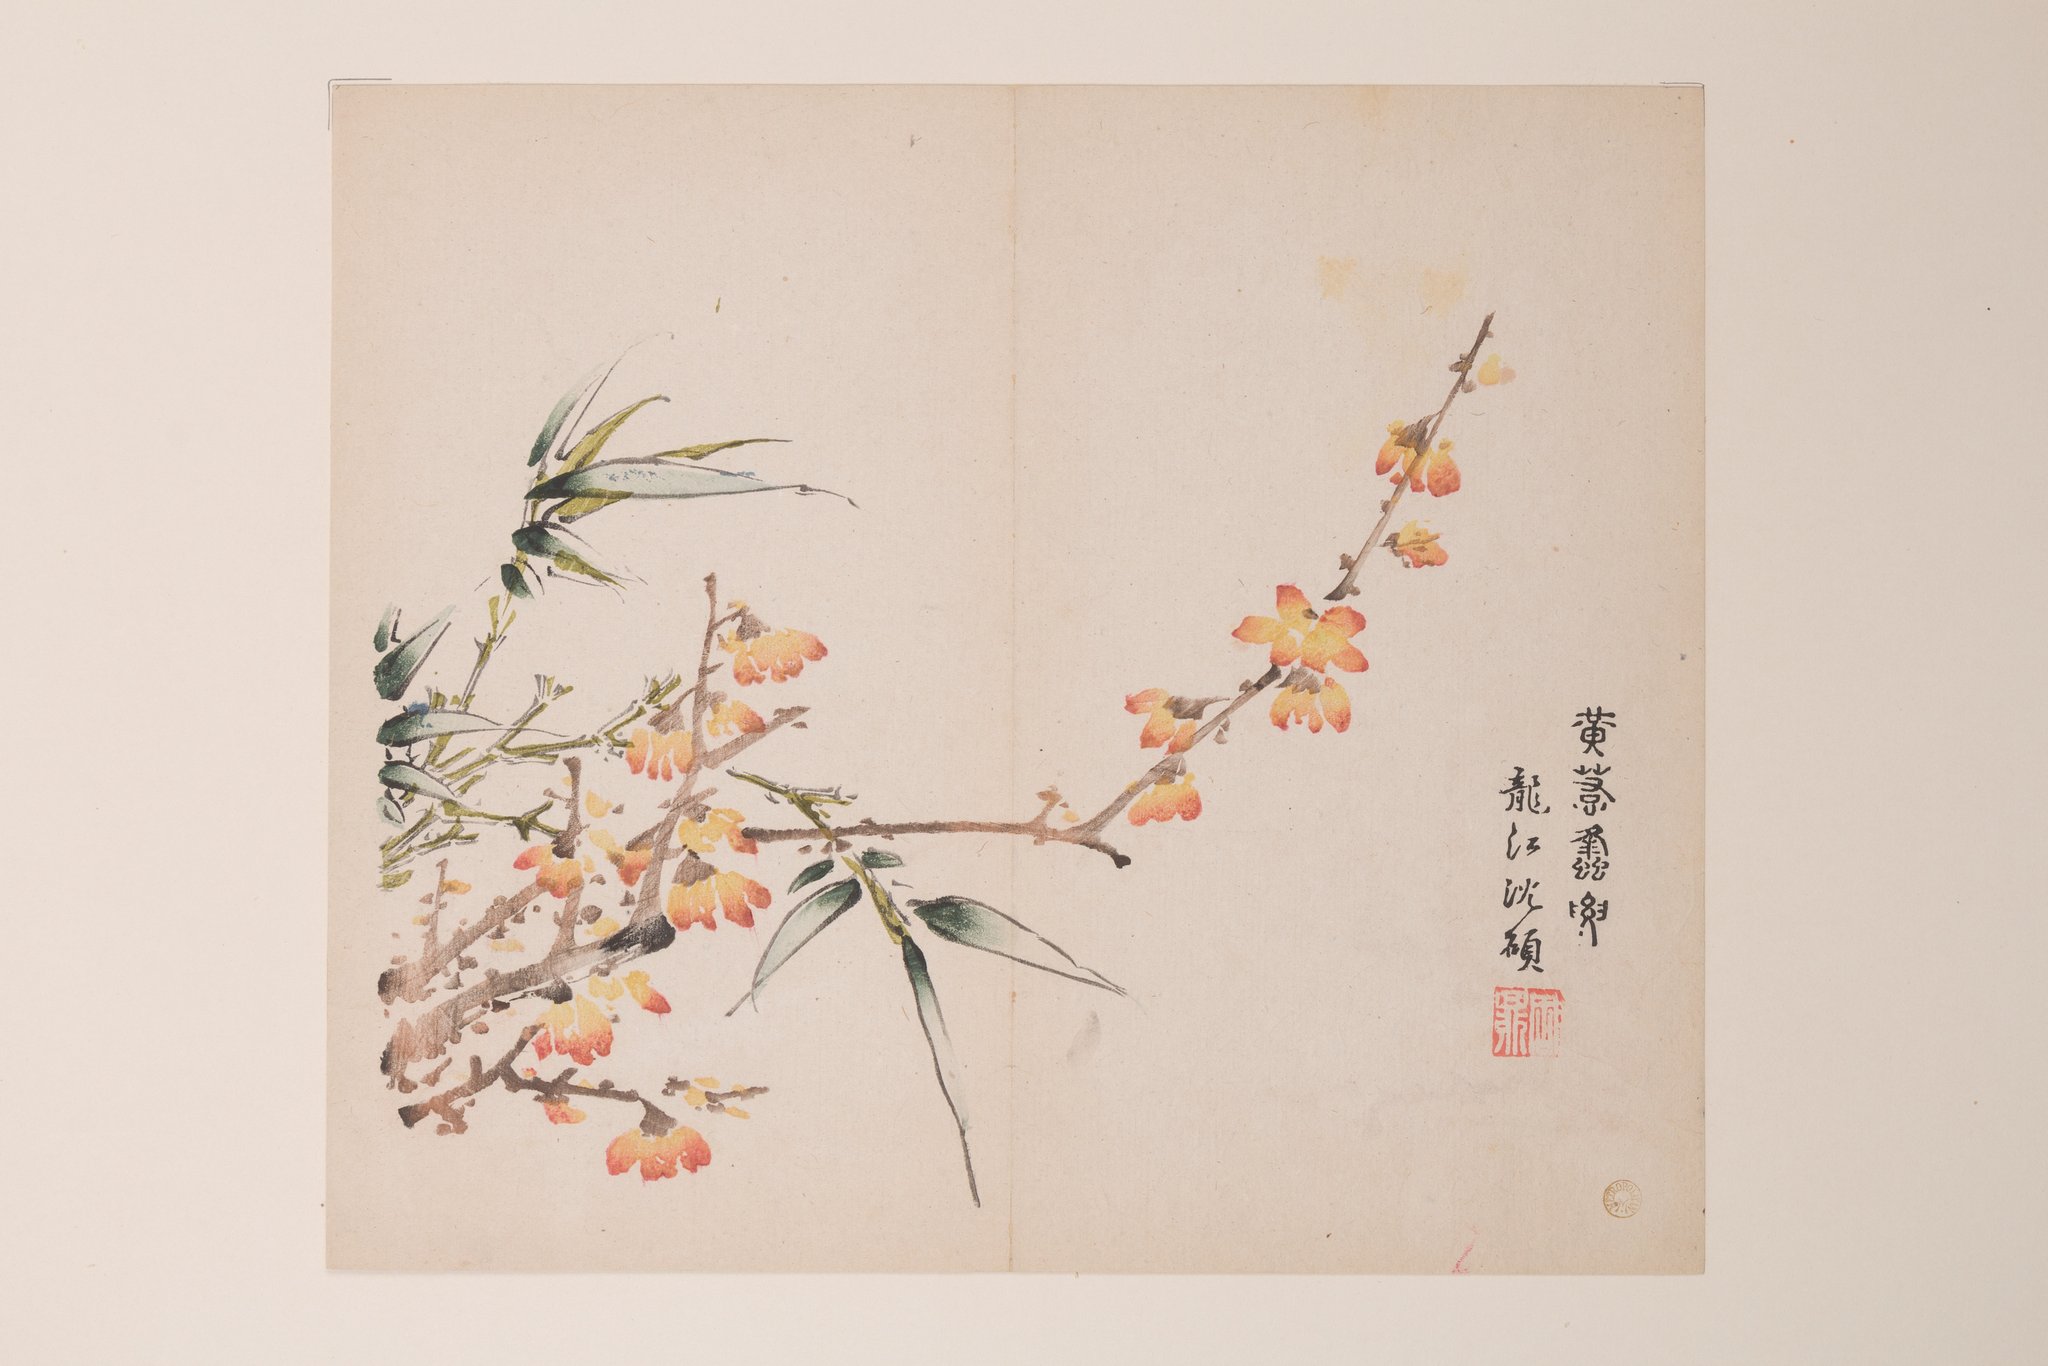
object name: print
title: Page from Shi Zhu Zhai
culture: chinese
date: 1662-1722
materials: ink, paper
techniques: polychrome, woodblock print